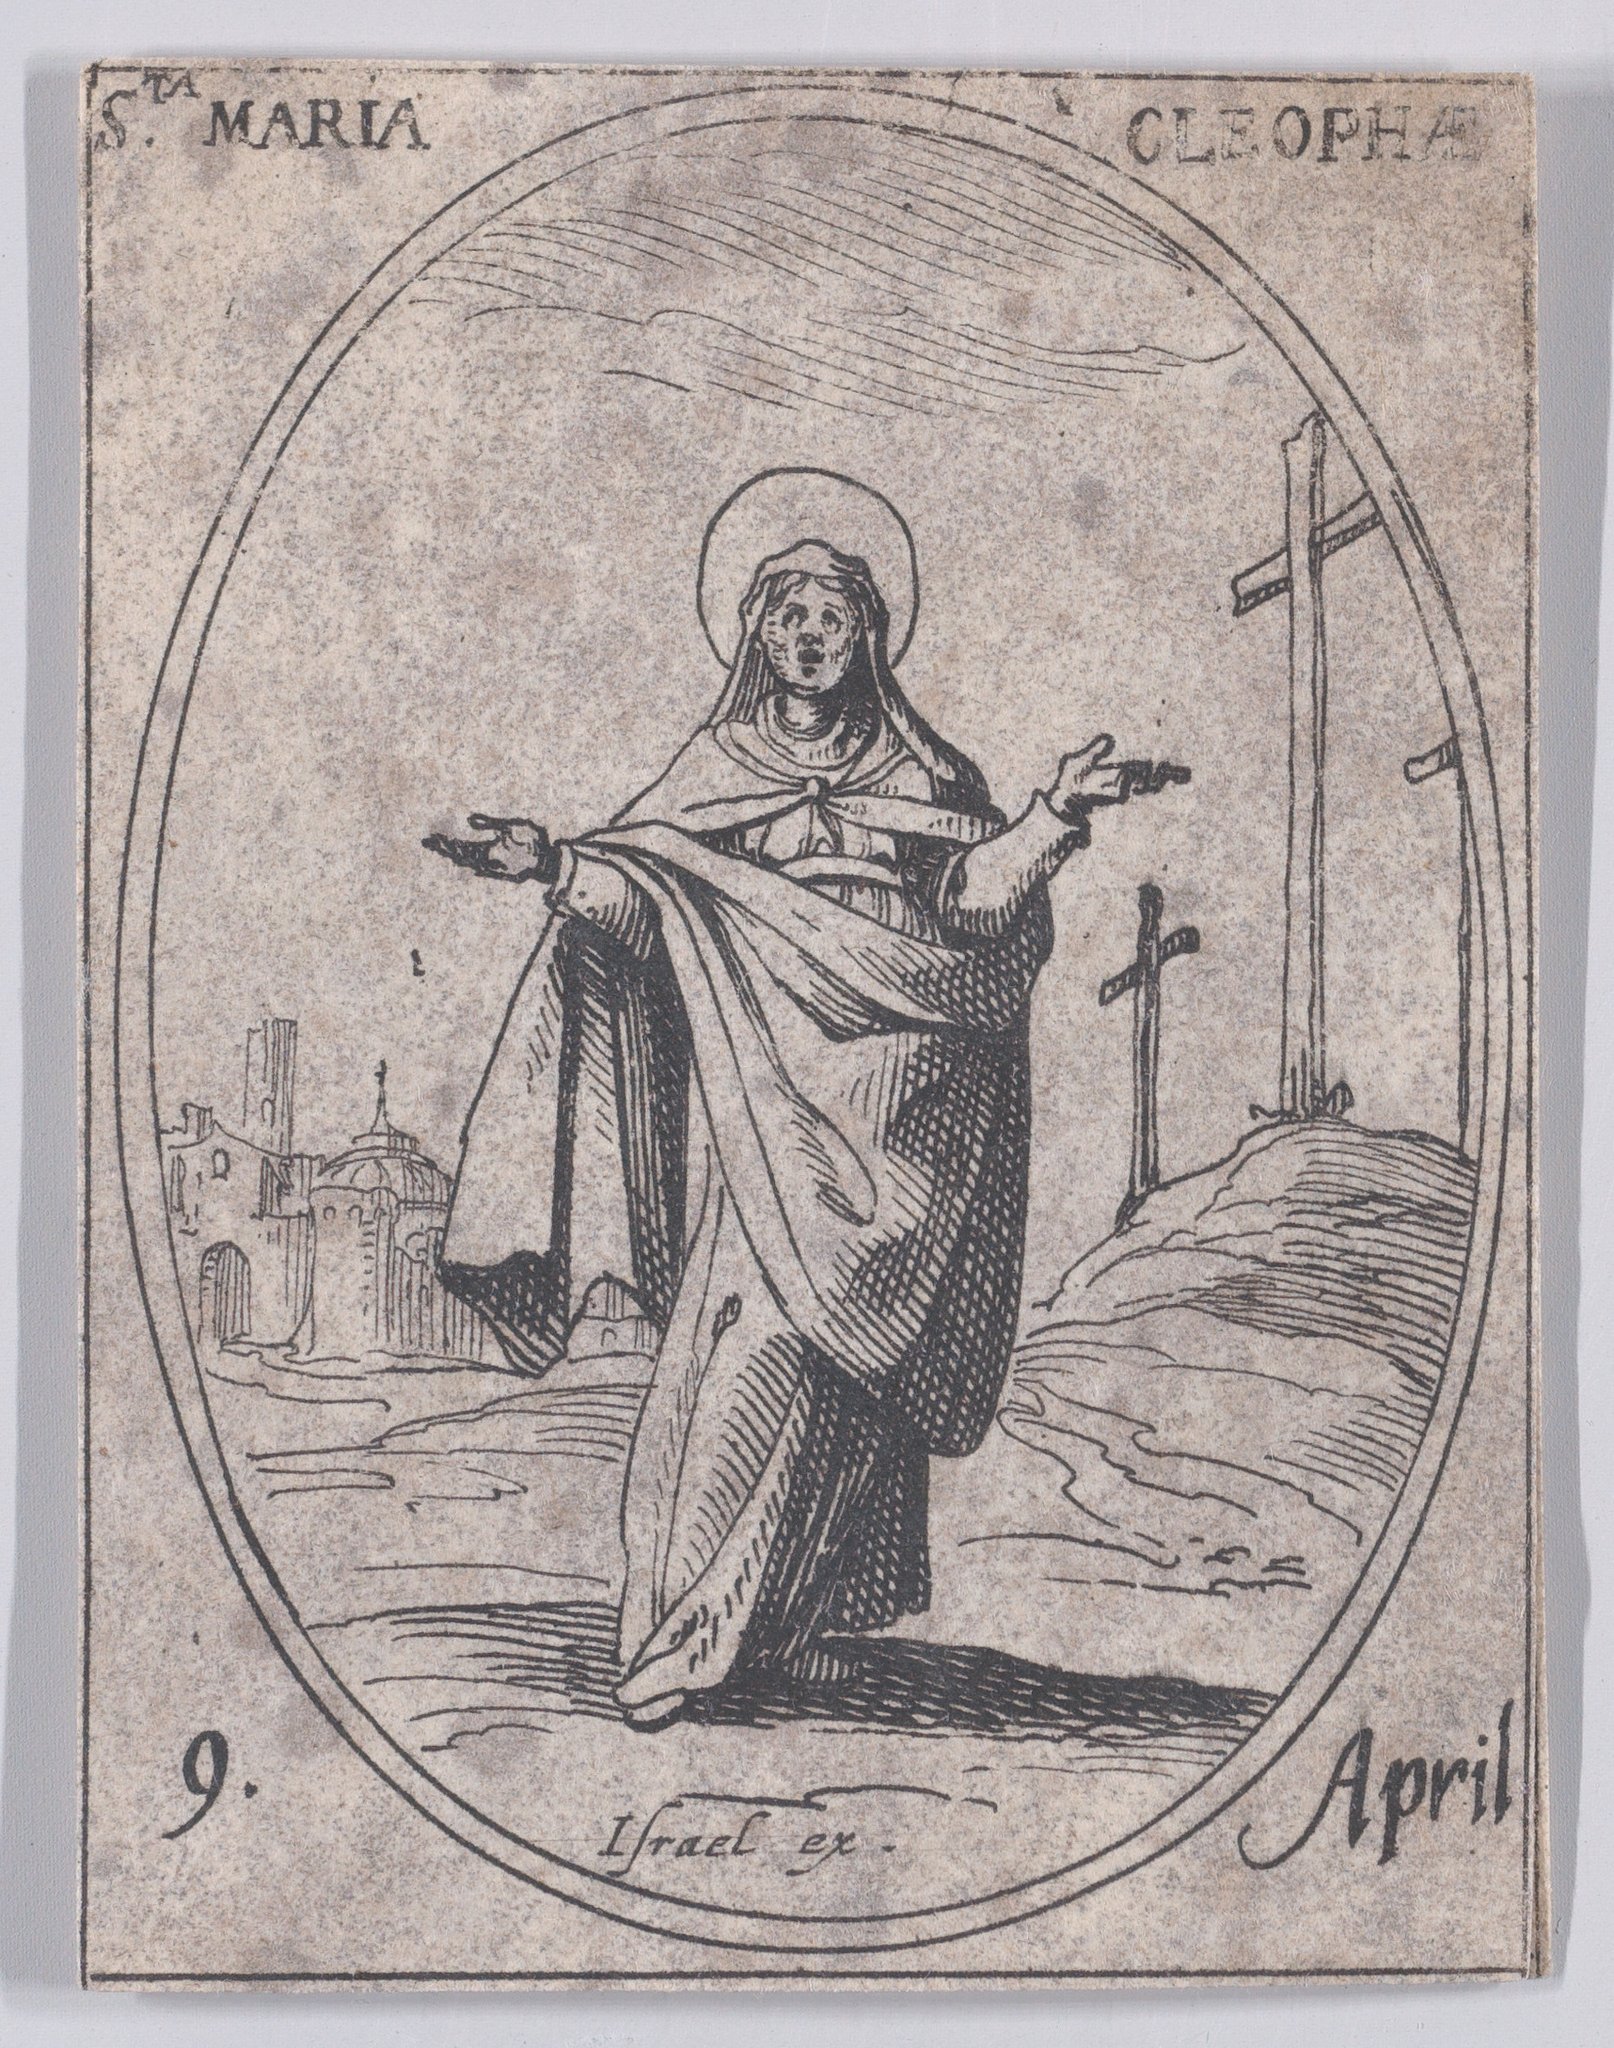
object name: print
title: Ste. Marie Cléophée (St. Mary Cleophas), April 9th, from "Les Images De Tous Les Saincts et Saintes de L'Année" (Images of All of the Saints and Religious Events of the Year)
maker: jacques callot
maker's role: artist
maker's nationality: french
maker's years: 1592-1635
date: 1636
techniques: etching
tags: women,saints